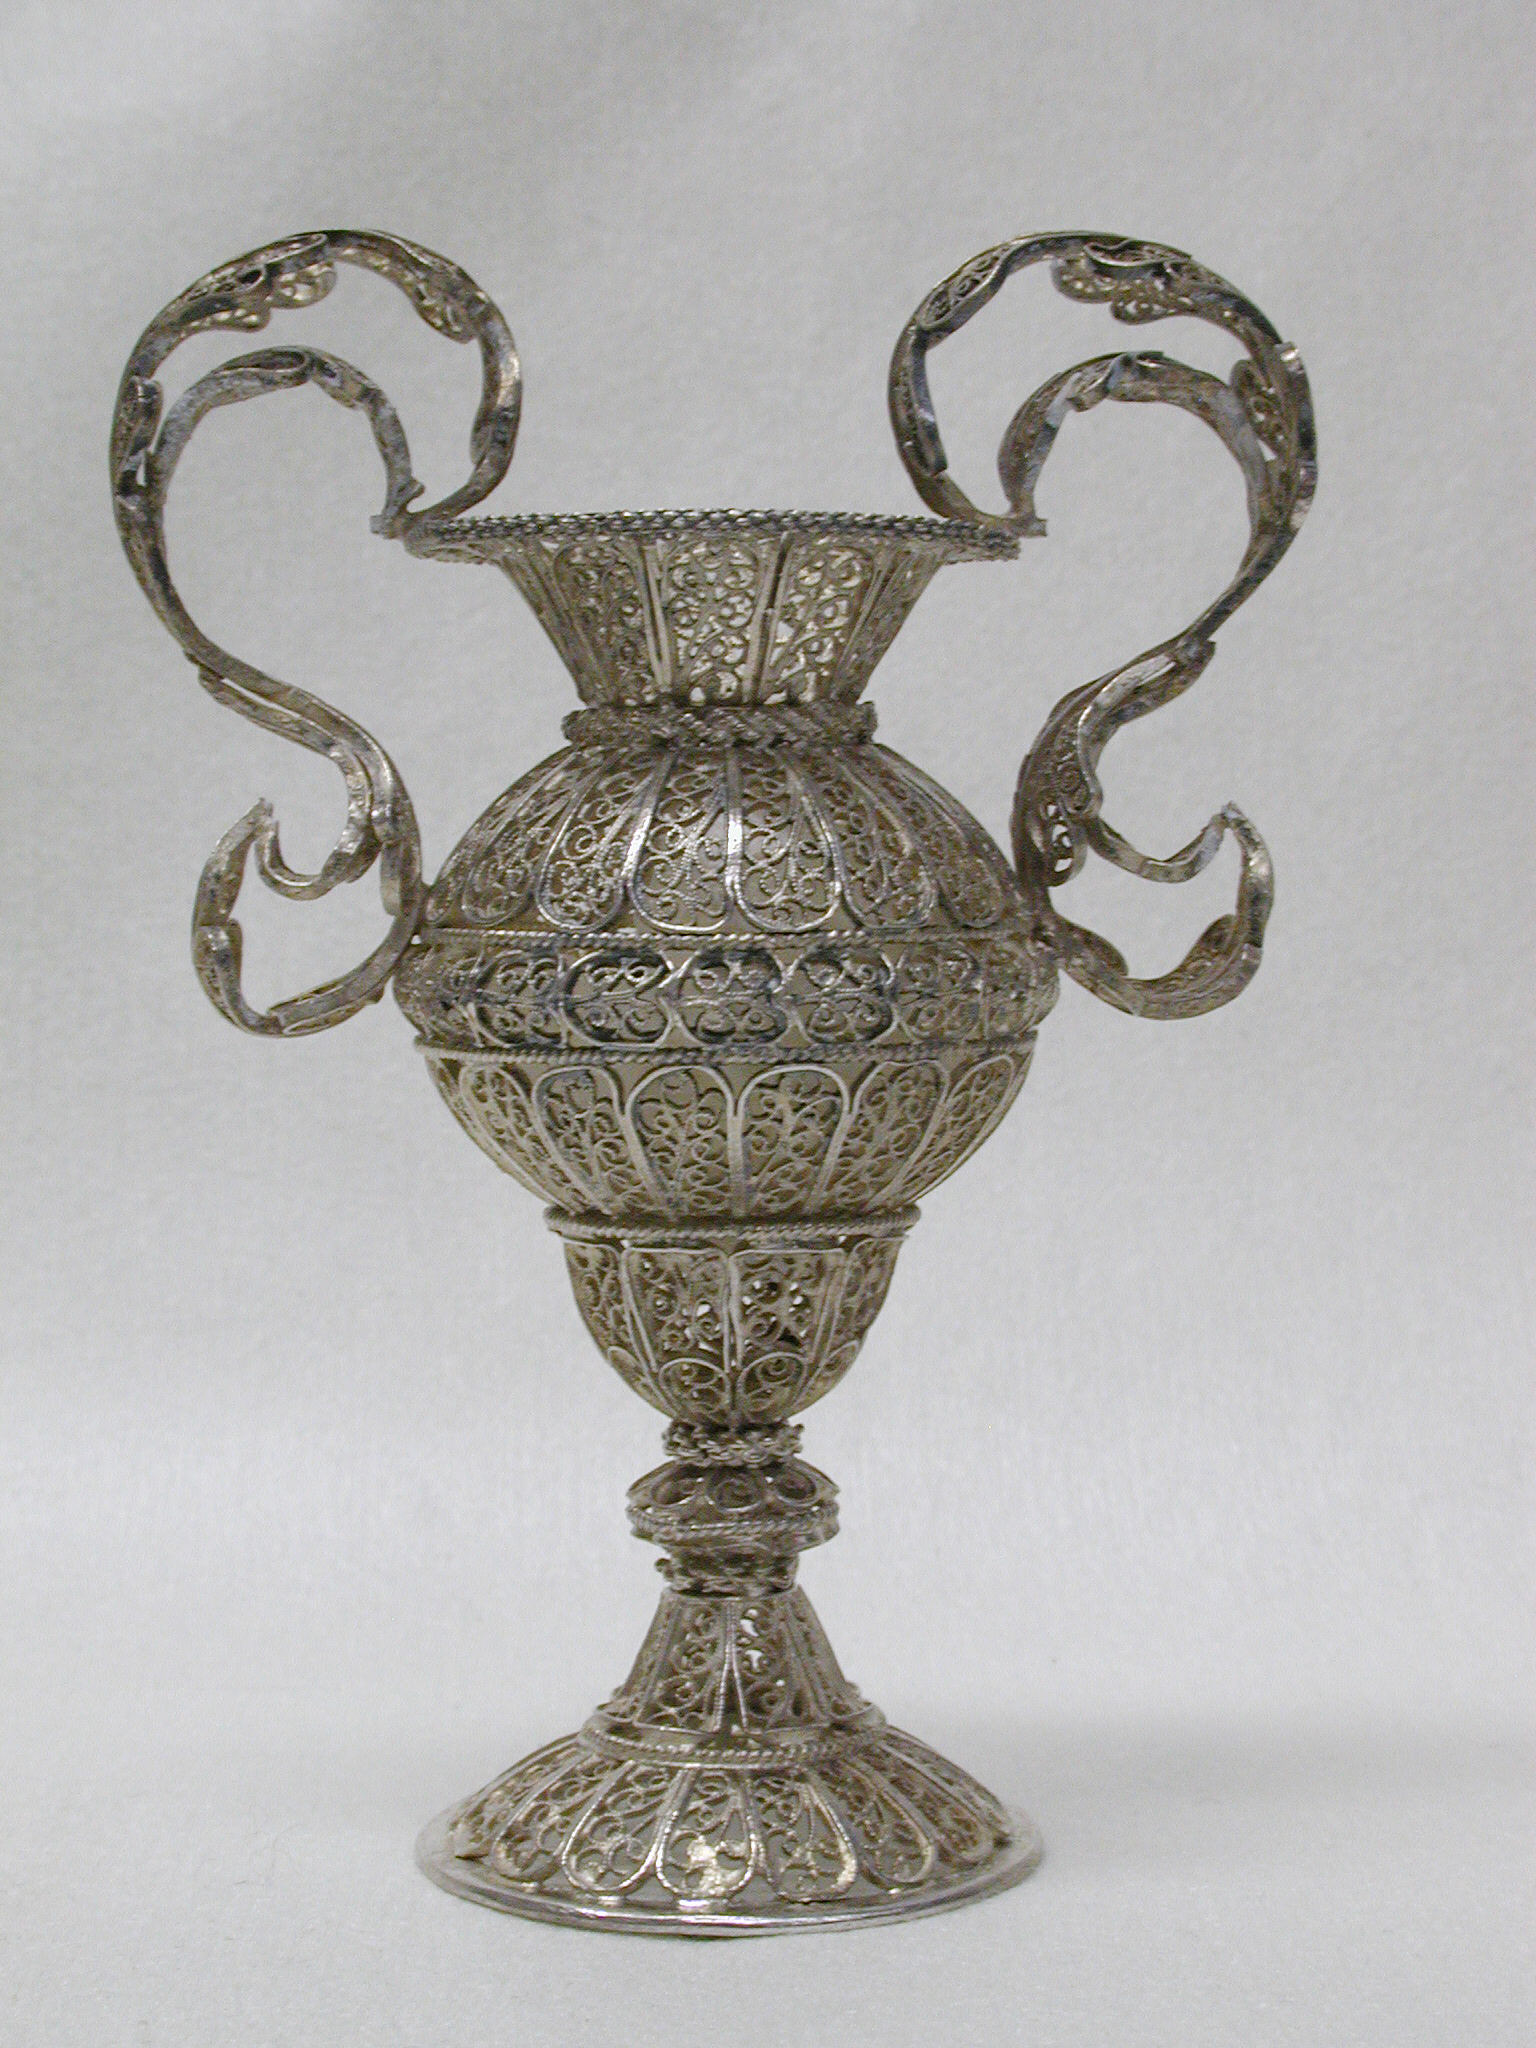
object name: urn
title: Miniature urn (one of a pair) (part of a set)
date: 1675-1700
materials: silver